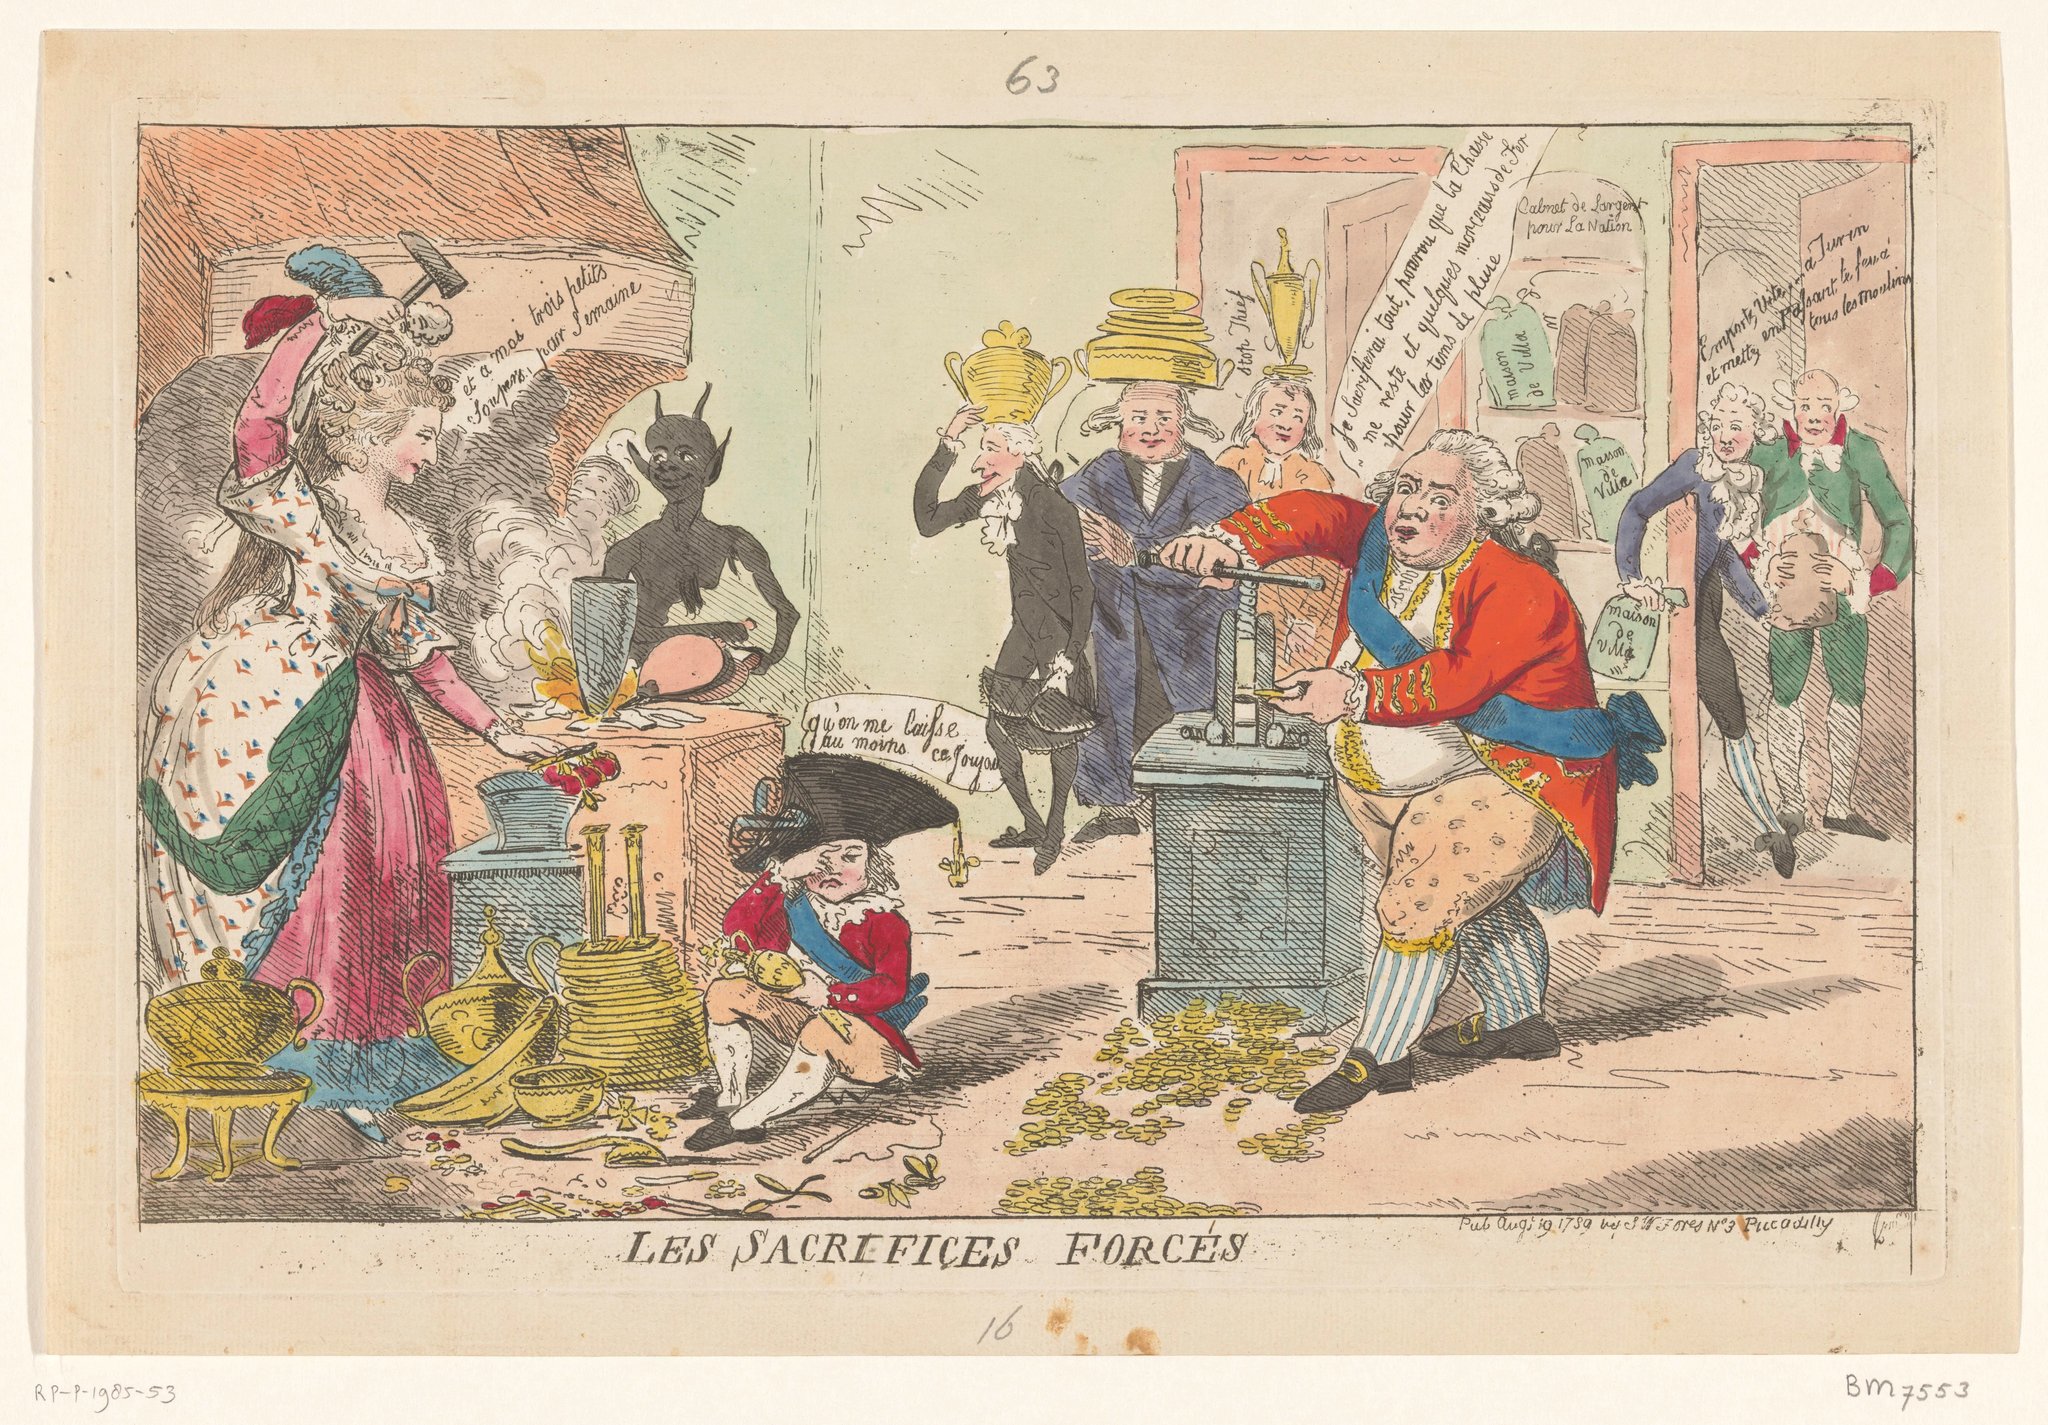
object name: cartoon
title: Spotprent op Marie Antoinette en Lodewijk XVI, 1789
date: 1789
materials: paper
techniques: etching, hand coloring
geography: england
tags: paris, lodewijk xvi (koning van frankrijk), vienna, marie antoinette, preparing of material by melting, smith, blacksmith, political caricatures and satires, container of precious metal, minter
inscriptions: collector's mark: Lugt 2760, collector's mark: Lugt 2228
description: Spotprent waarin koningin Marie Antoinette en koning Lodewijk XVI gedwongen hun gouden huisraad en kronen omsmelten en tot muntgeld persen. De duivel wakkert met een blaasbalg het vuur in de smederij aan, op de grond speelt de dauphin met een scepter. Met enkel Franse opschriften.